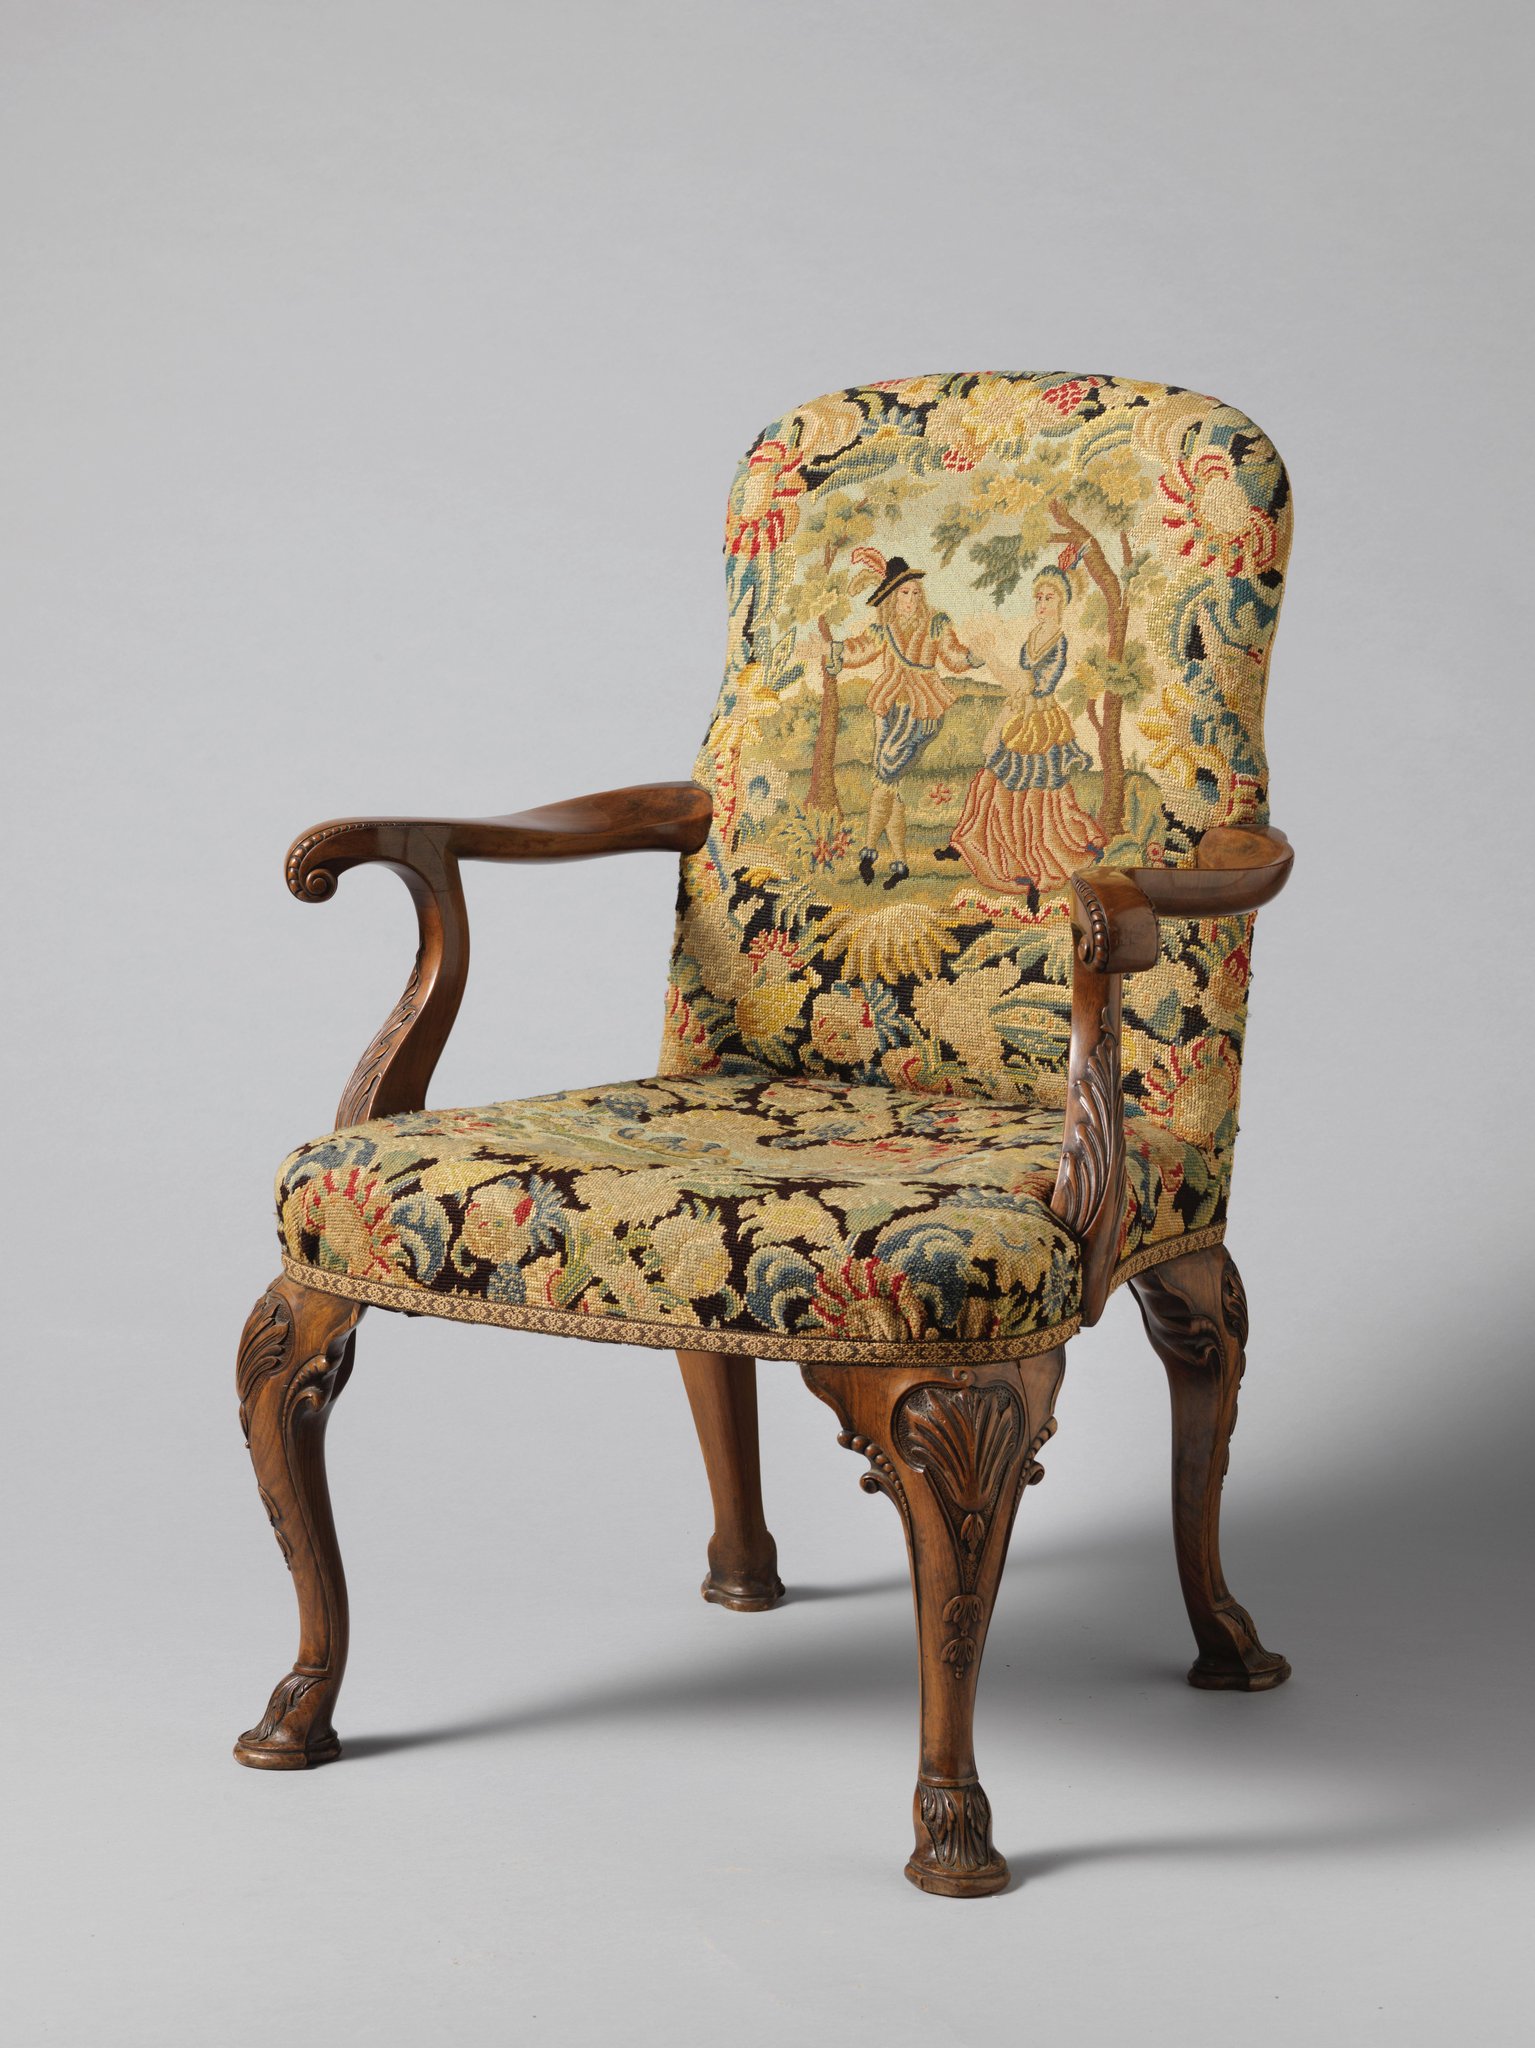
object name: chair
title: Armstoel van notenhout met een bekleding van gros- en petitpoint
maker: Anonymous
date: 1750-1775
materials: textile, wood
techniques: embroidered, gros point, petit point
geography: northern netherlands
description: Armstoel (van een paar), met een bekleding van gros- en petitpoit. De overhoeks geplaatste gestrekt S-vormige poten eindigen in platte bokshoeven en dragen versieringen van gesneden acanthusblad op de zwellingen. Hetzelfde motief komt voor op de S-vormig gebogen armleggerstutten, die de flauw gewelfde armleggers, eindigend in een voluut, steunen. Trapeziumvormig zitraam. De bekleding vertoont vogels en een mannen- en vrouwenfiguur. Zie: BK-1955-43-B; moderne stoelen.